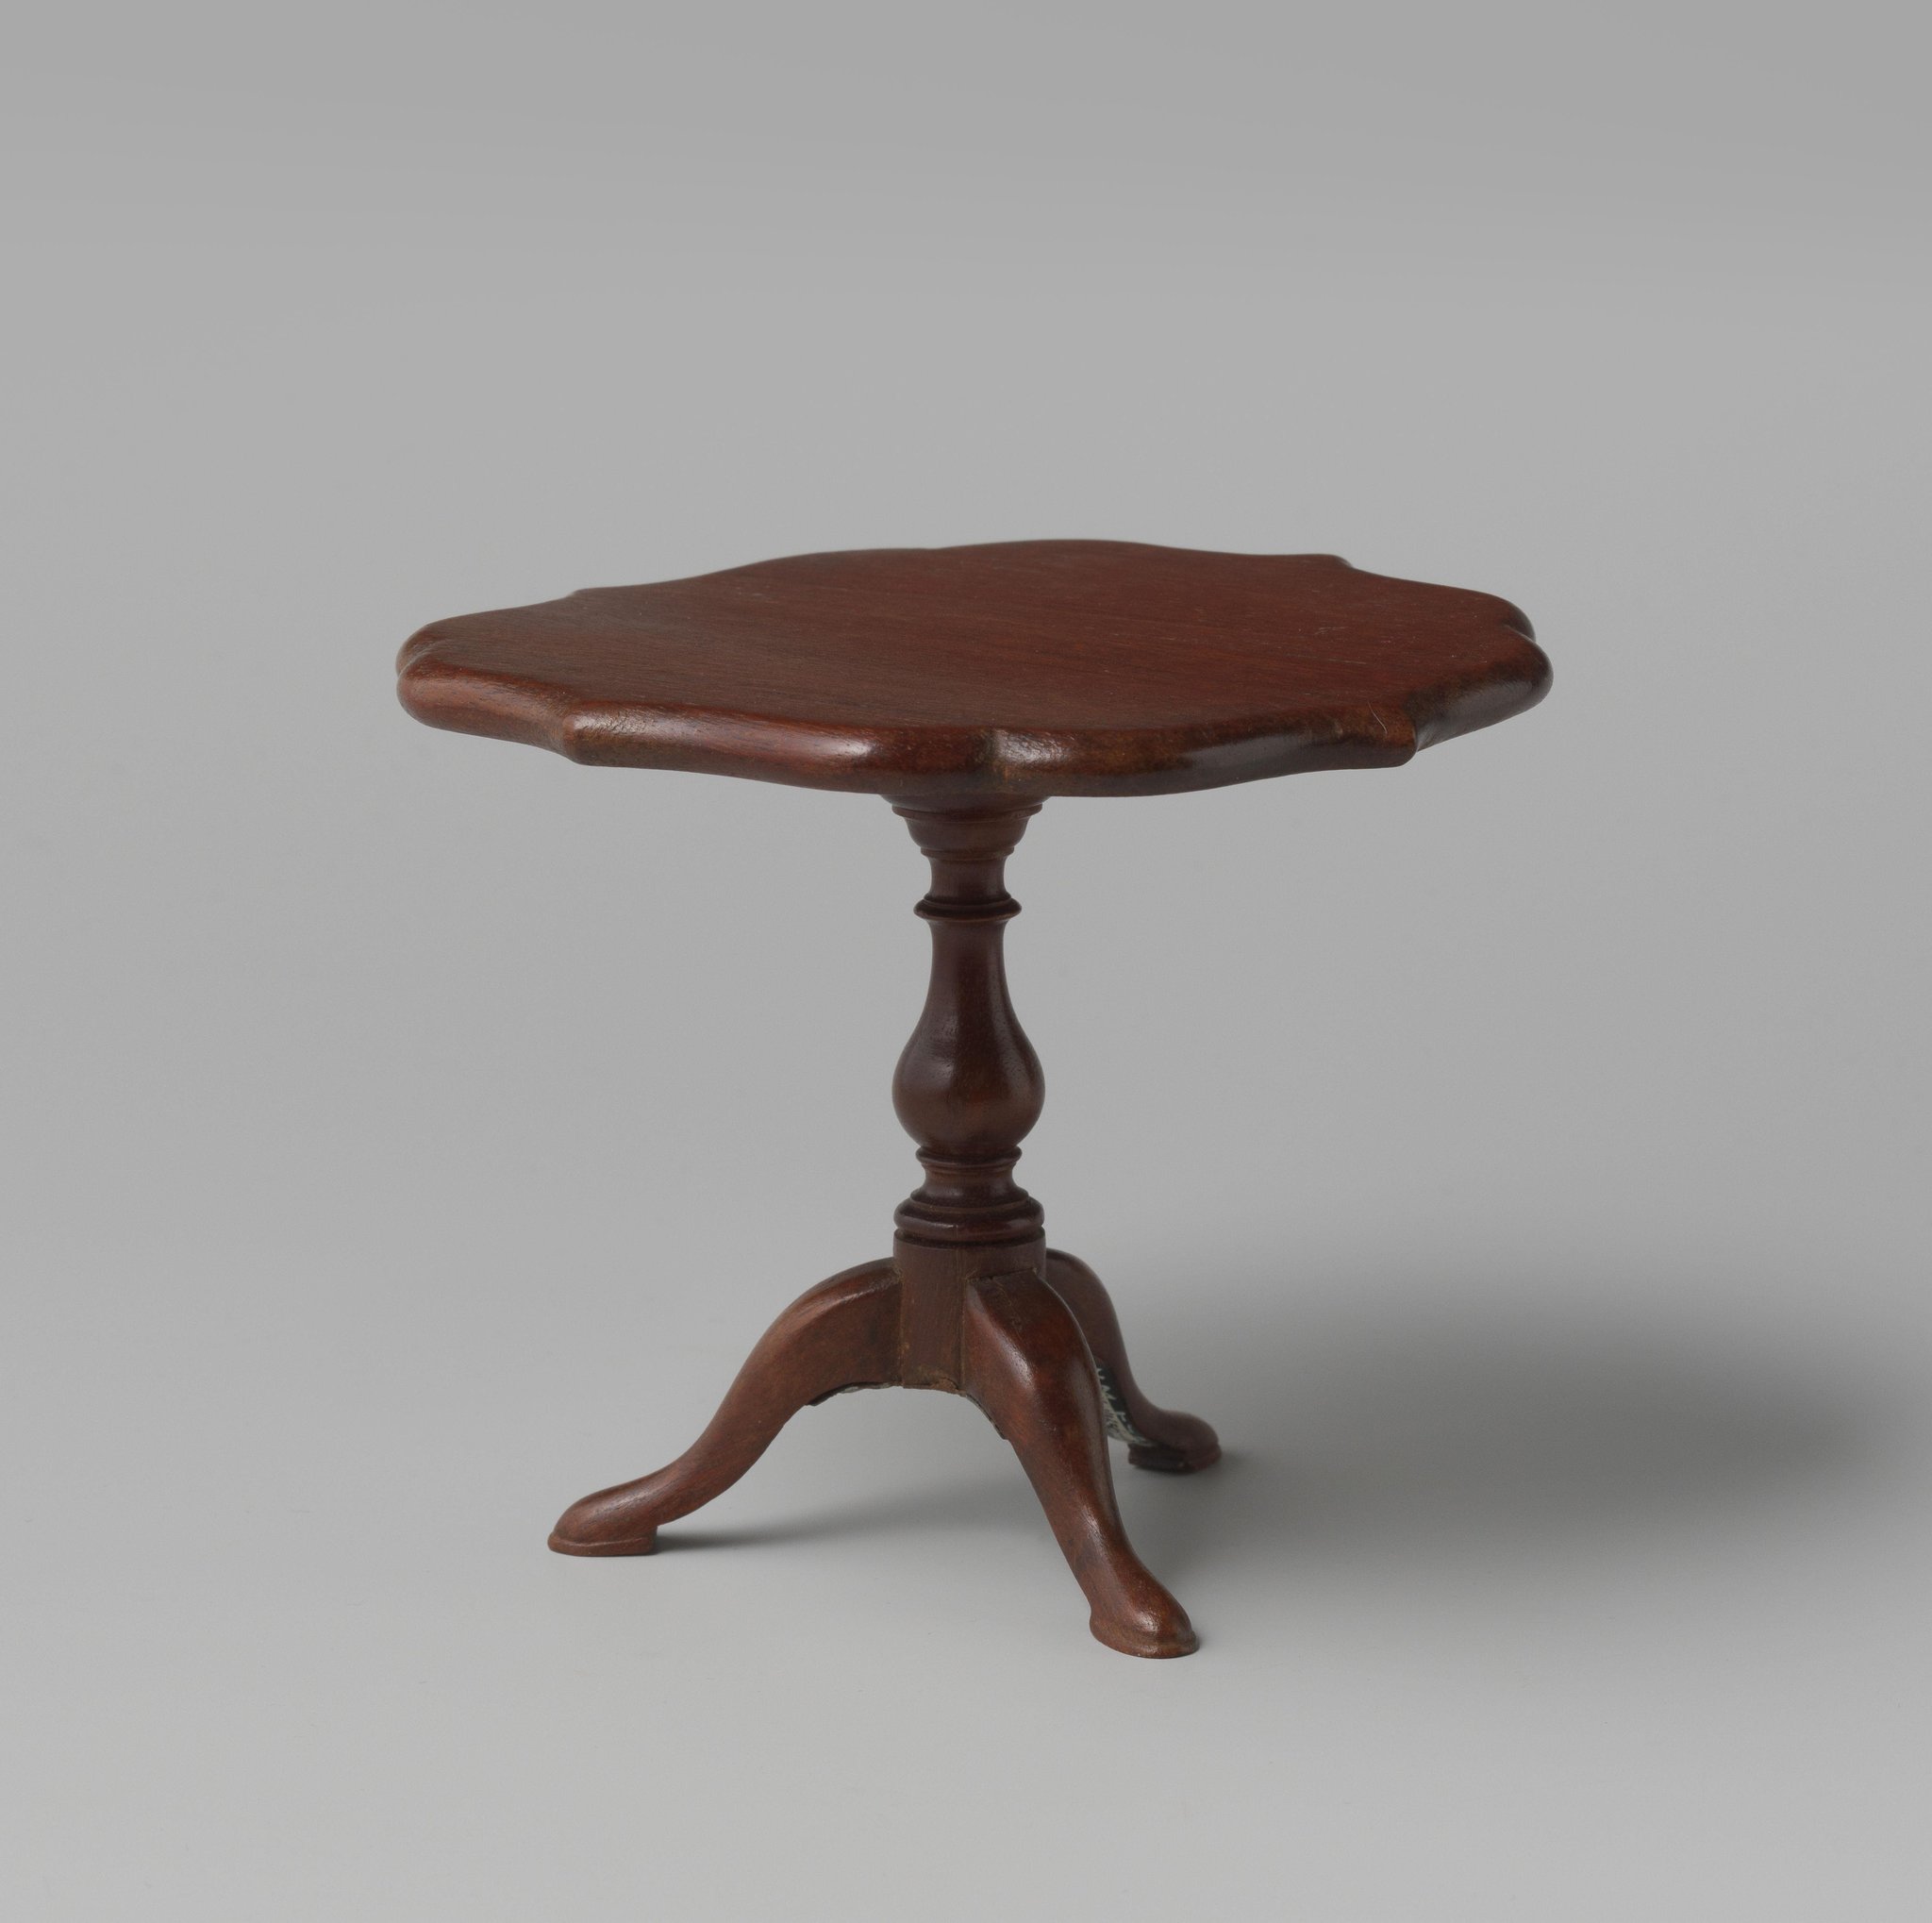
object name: miniature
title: Tafel met blad met golvende rand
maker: Anonymous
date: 1750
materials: wood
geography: amsterdam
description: Tafel, vervaardigd van mahoniehout. Het blad, met accoladevormig gegolfde rand, rust op een balustervormige stam, en drie straalsgewijs geplaatste, gebogen voeten.